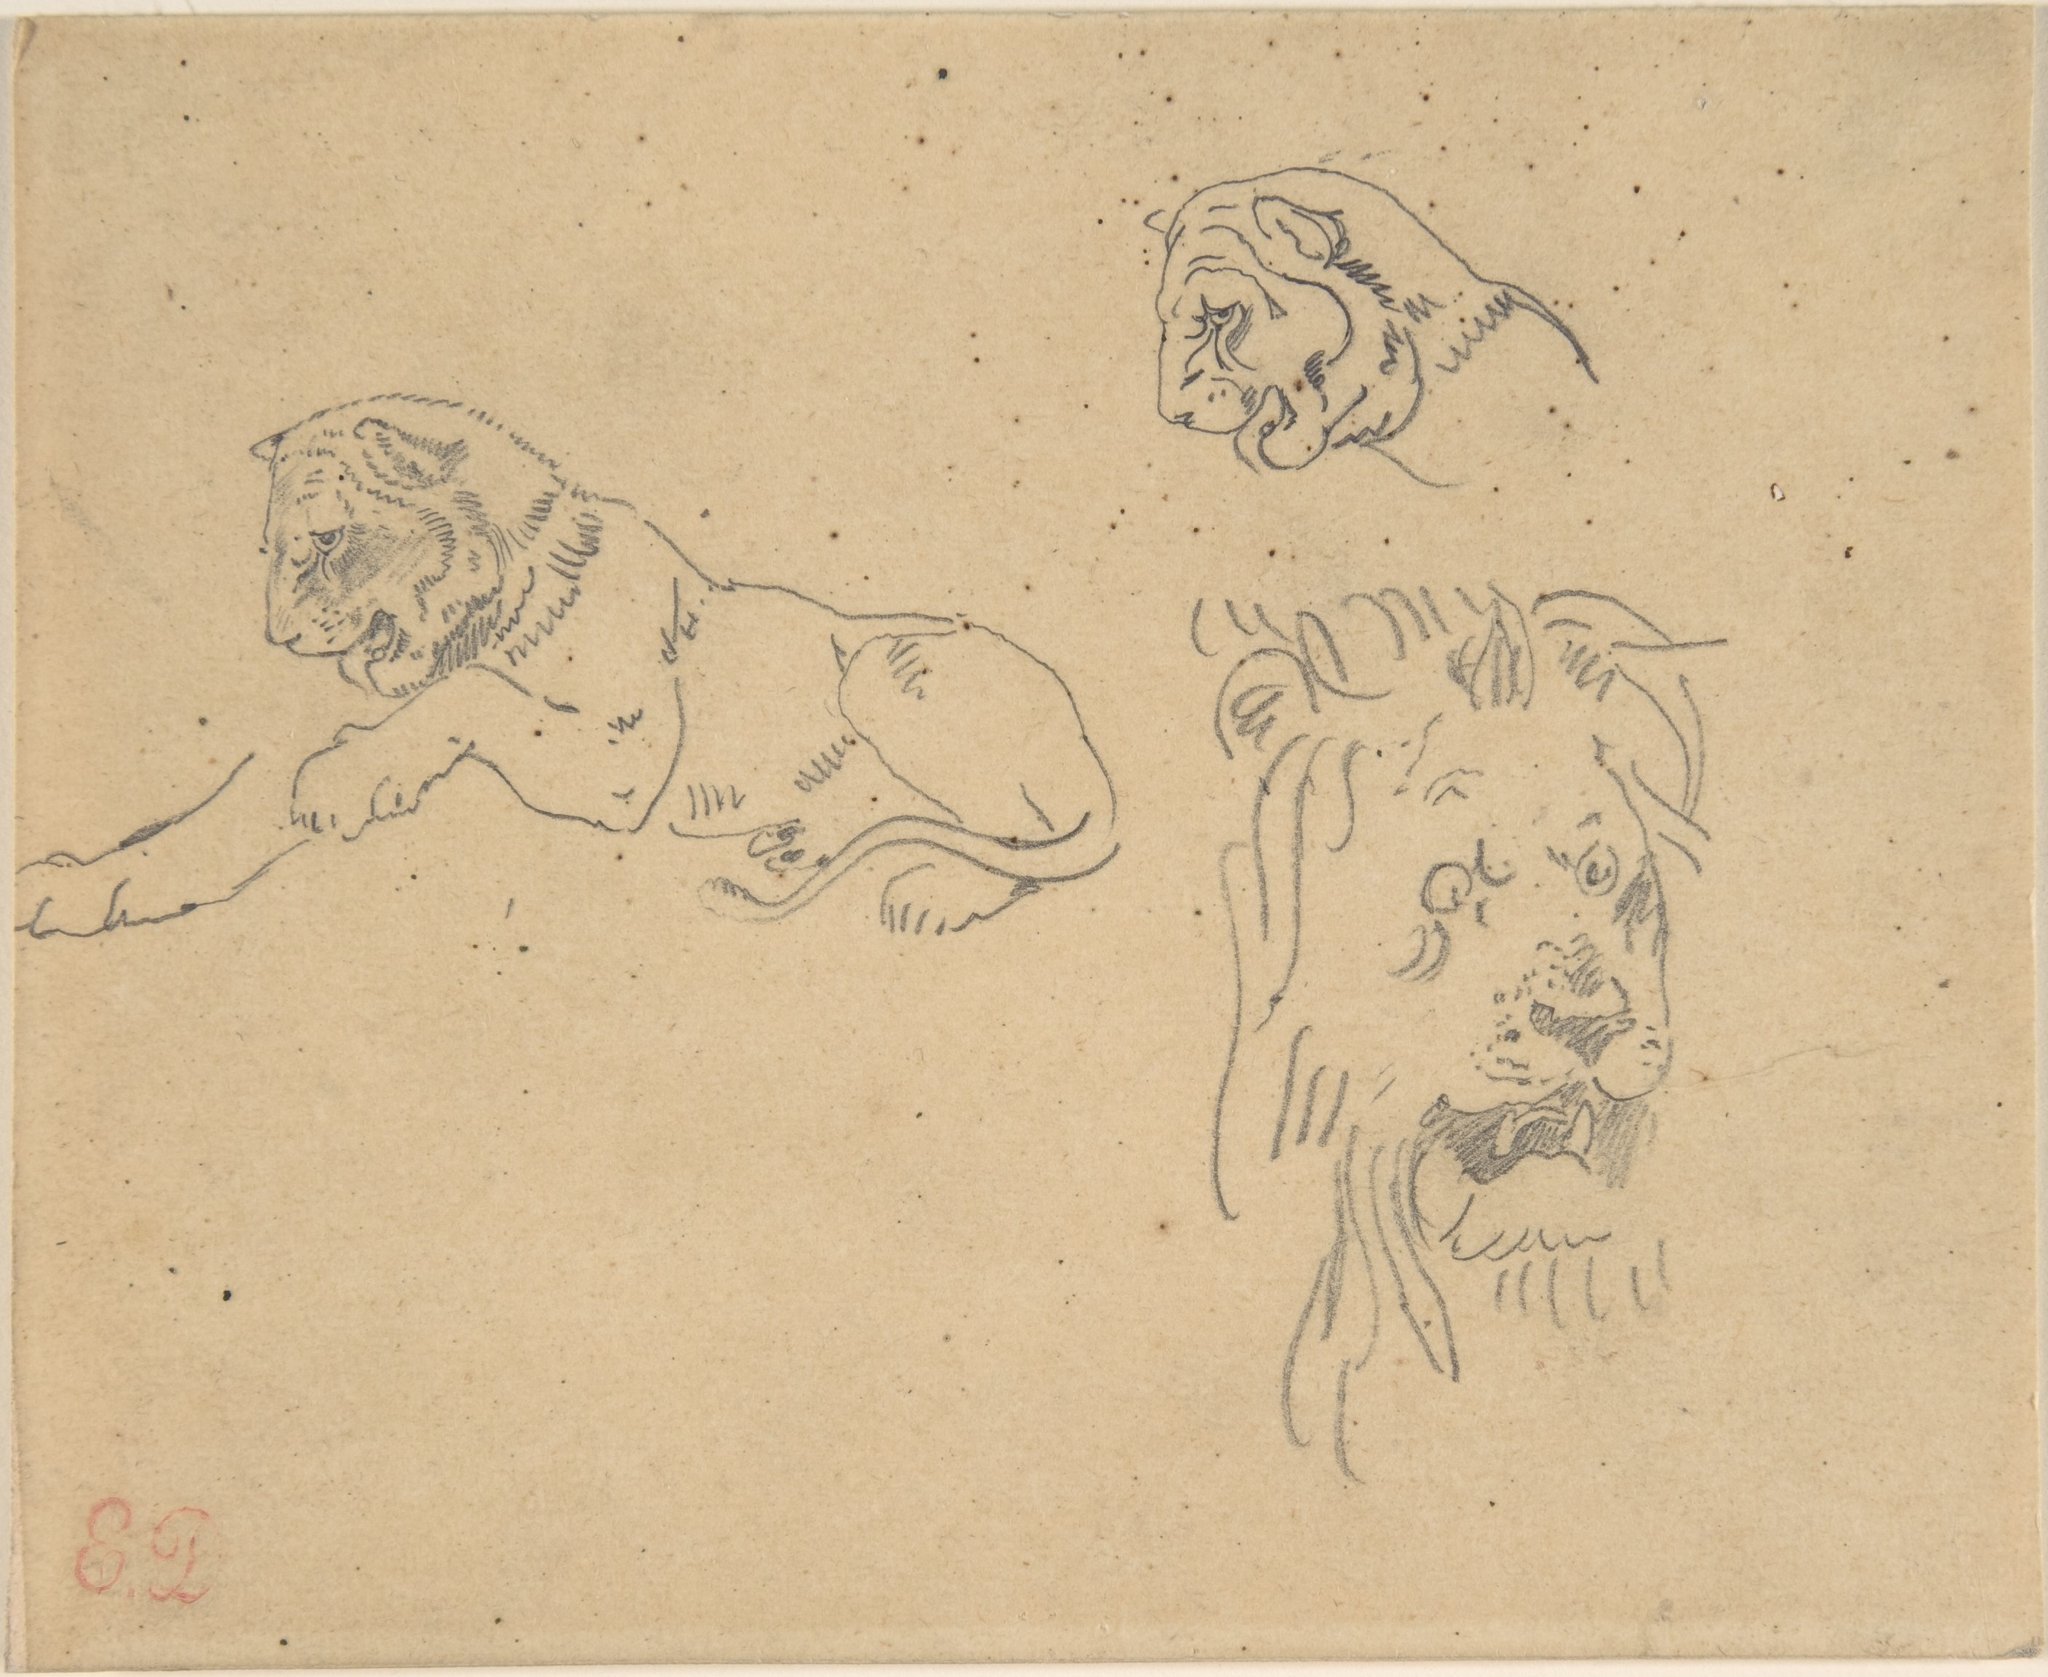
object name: drawing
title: Three Studies of a Lion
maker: eugène delacroix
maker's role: artist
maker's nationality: french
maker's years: 1798-1863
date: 1815-1863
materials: graphite, paper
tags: lions